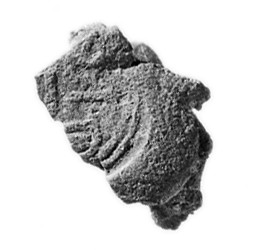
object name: sealing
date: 1981-1640 BCE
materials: mud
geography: egypt